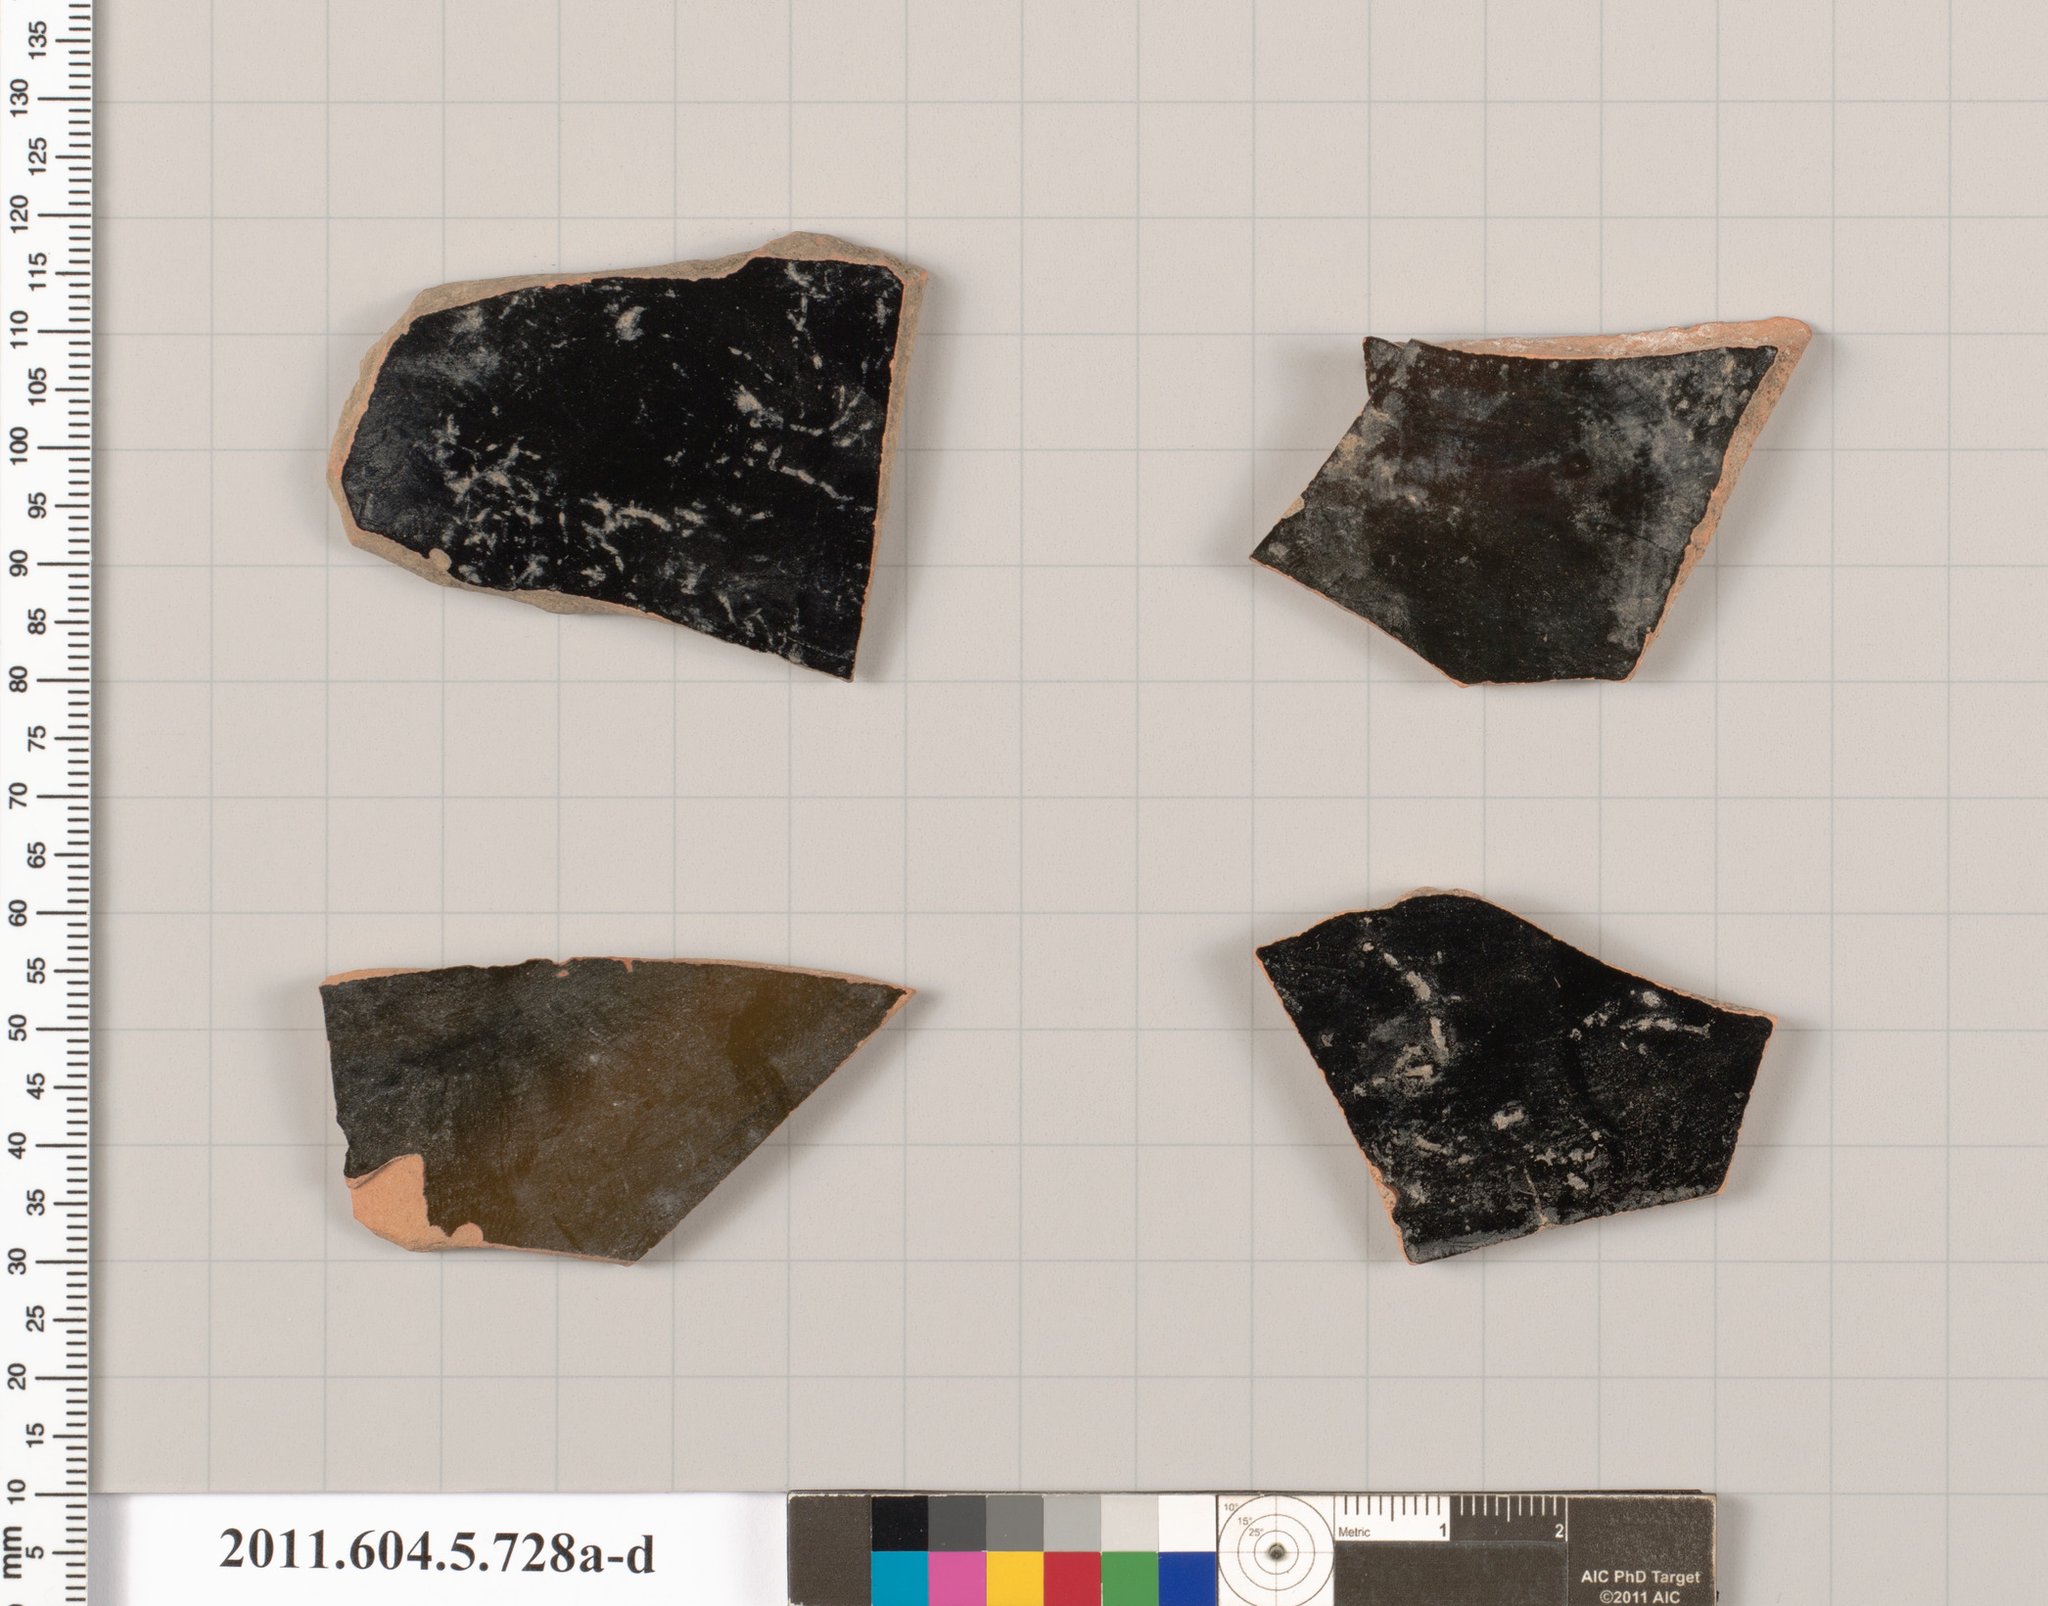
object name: kylix fragment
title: Terracotta fragments of kylikes (drinking cups)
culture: greek, attic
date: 600-401 BCE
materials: terracotta